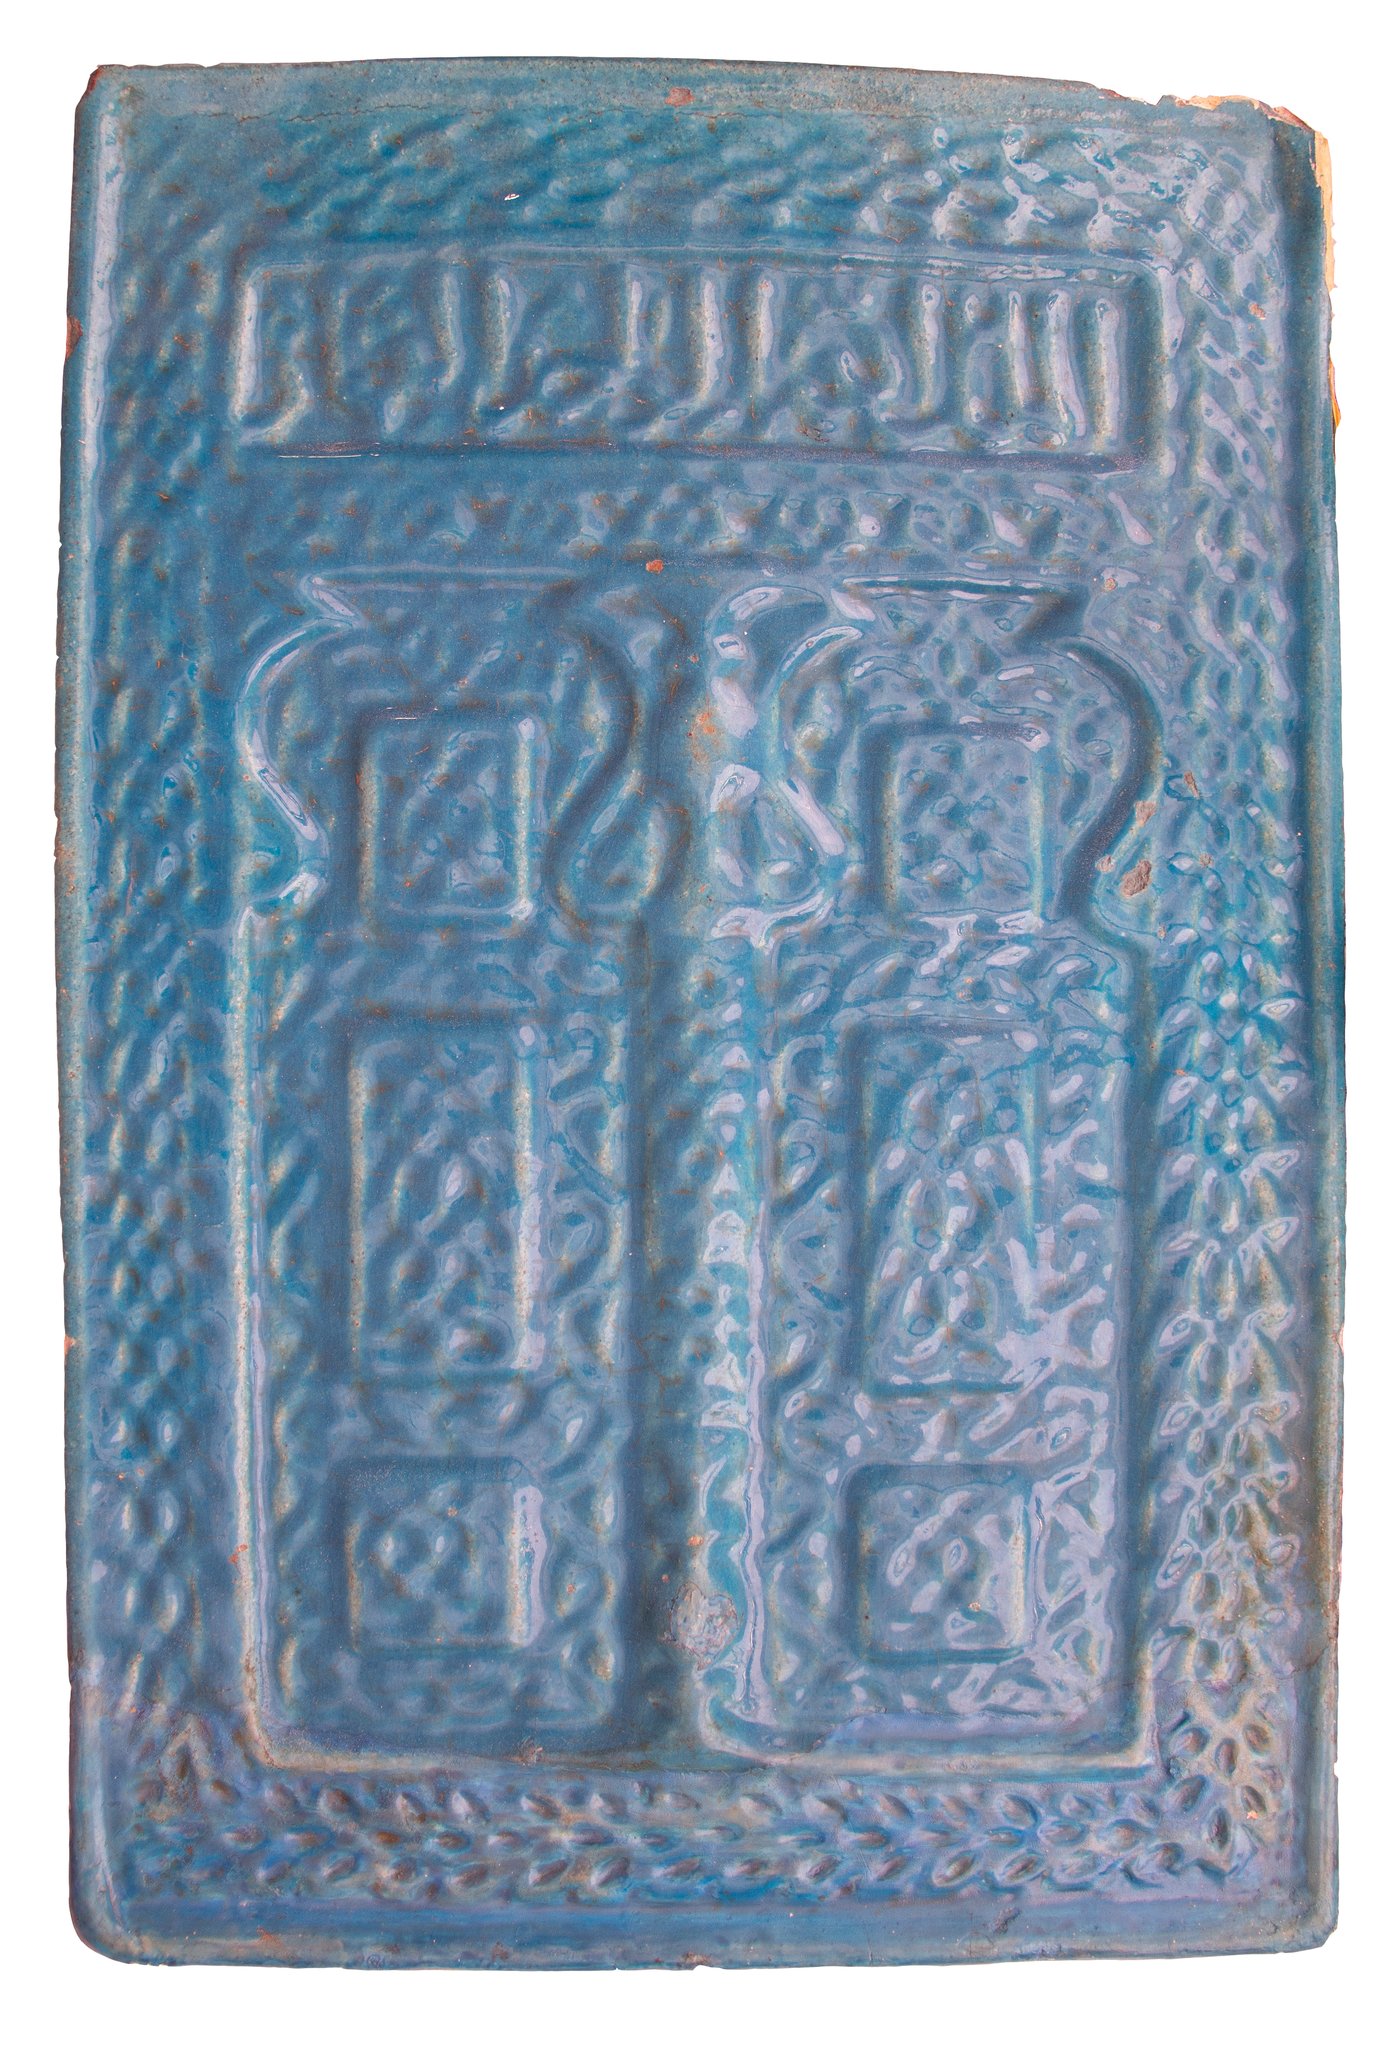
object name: tile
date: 1301-1400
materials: stonepaste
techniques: glazing, molding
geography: iran